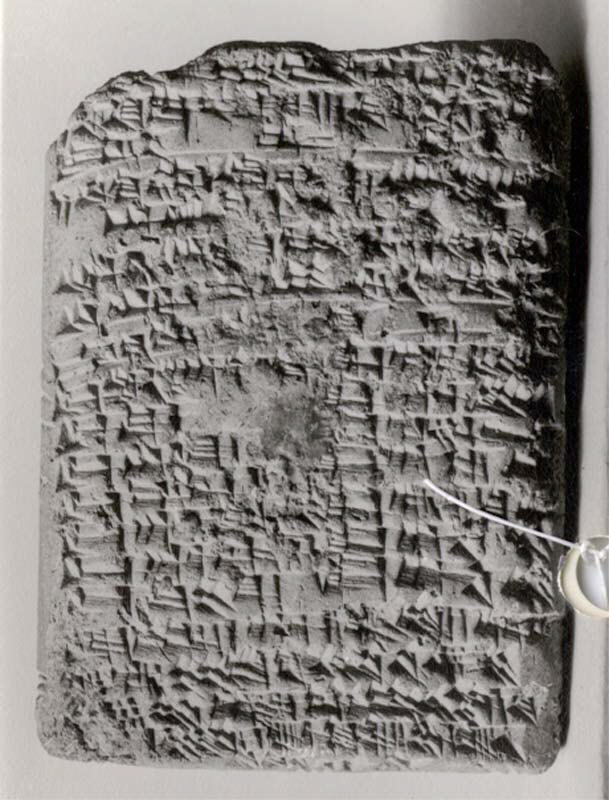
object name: cuneiform tablet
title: Cuneiform tablet: purchase of a field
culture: babylonian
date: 596 BCE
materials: clay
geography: mesopotamia